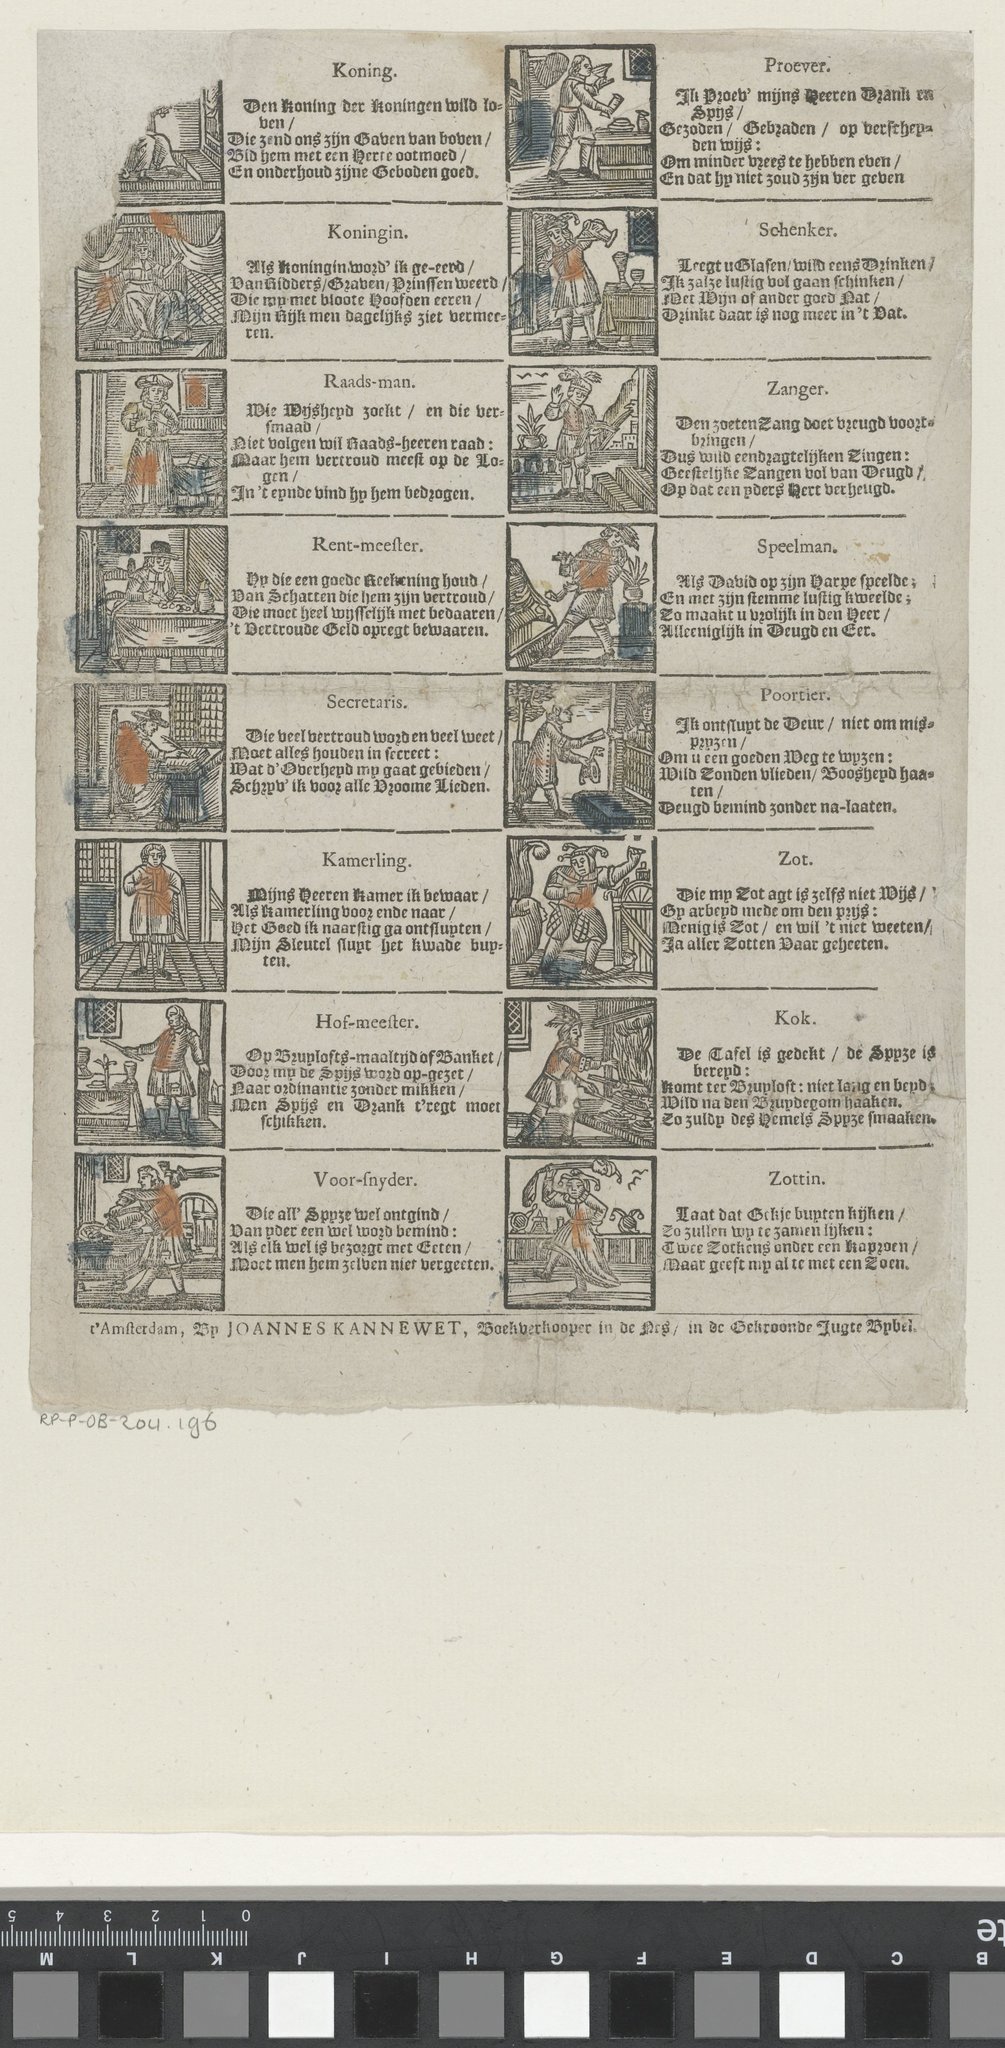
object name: popular print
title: Driekoningenbriefjes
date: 1725-1780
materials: paper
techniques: colour, letterpress printing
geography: amsterdam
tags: twelfth night, usually falling on the eve of january 6, royal household; courtiers, retinue, train, epiphany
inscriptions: collector's mark: Lugt 2760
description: Blad met 16 voorstellingen (driekoningenbriefjes) van verschillende functies binnen het hof, waaronder een raadsman, een proever en een portier. Rechts naast elke afbeelding een bijschrift.